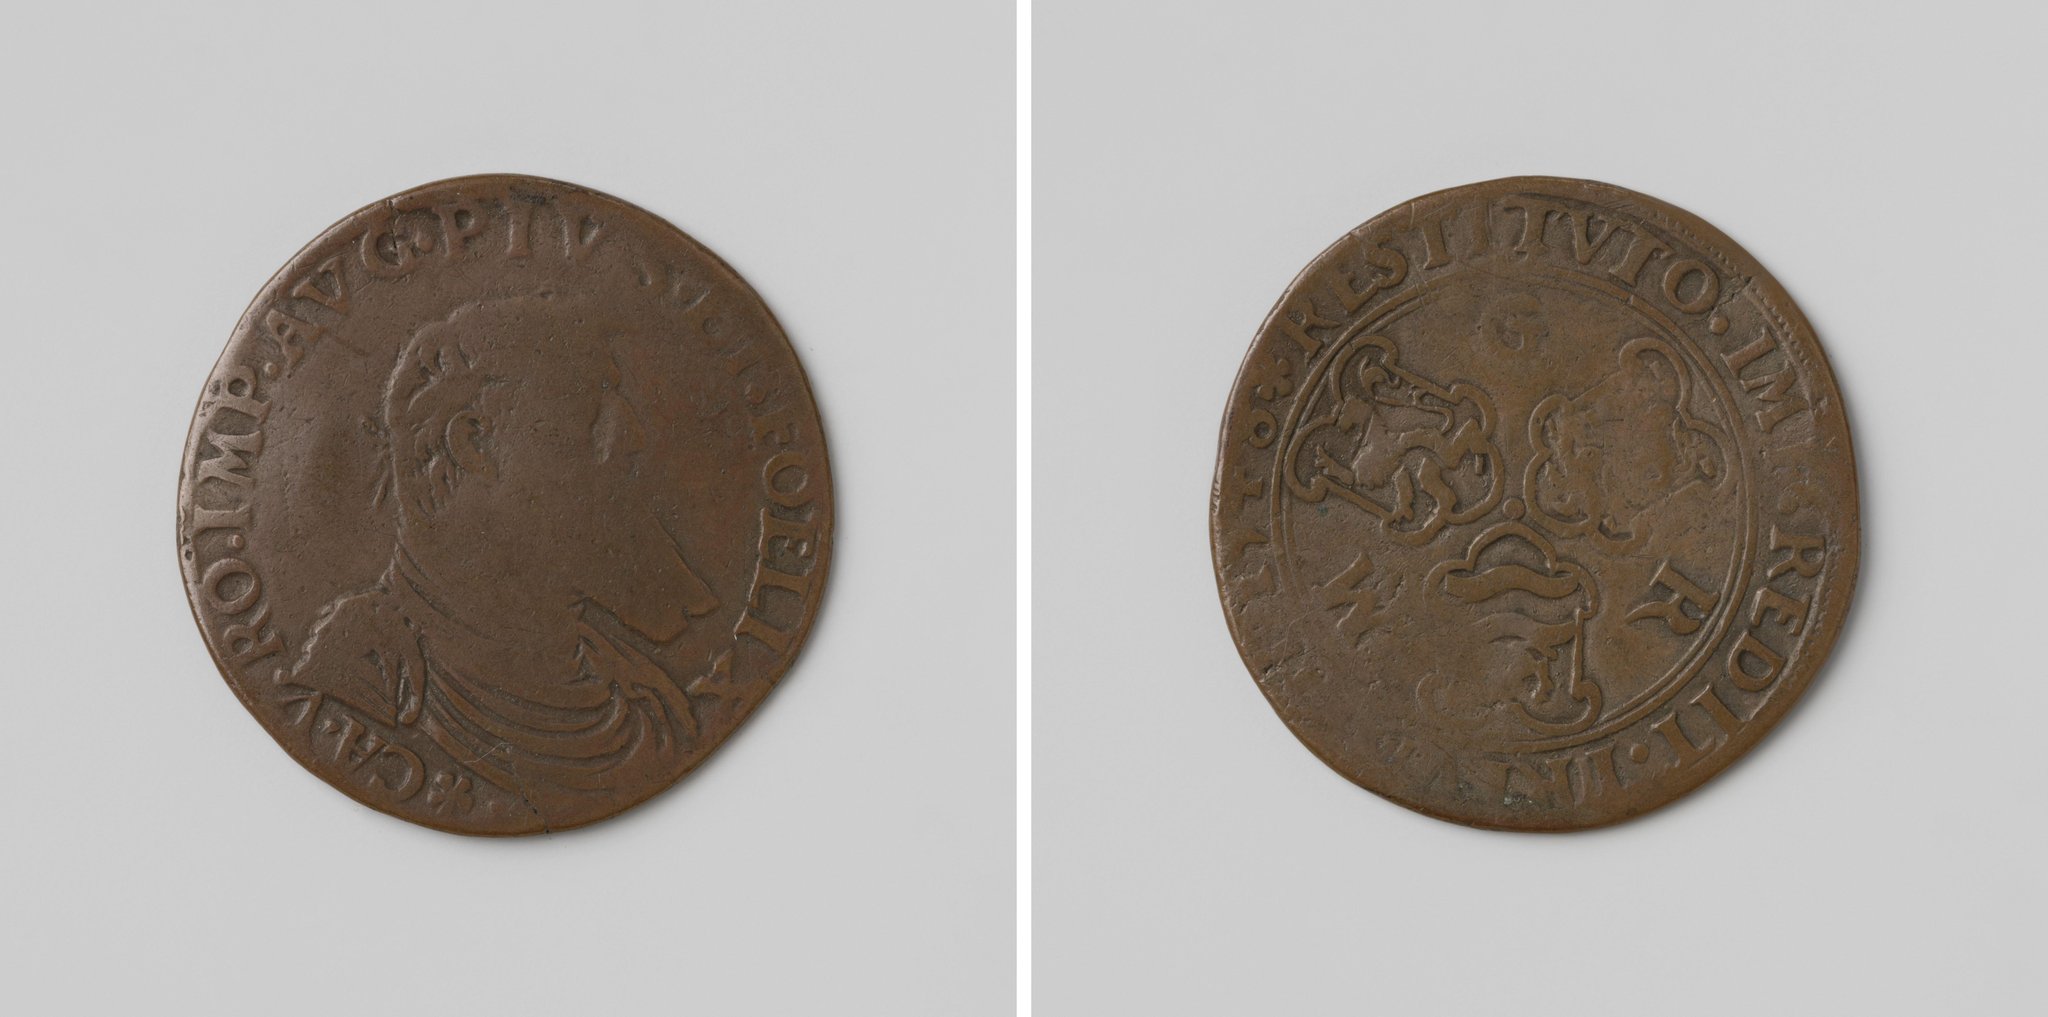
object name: jeton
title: Herstel van de vrede in Duitsland op het Interim van Augsburg, rekenpenning ten behoeve van Mr. Gerrit van Renoy, auditeur van de rekenkamer van Holland te 's-Gravenhage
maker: Anonymous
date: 1548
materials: copper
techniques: striking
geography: netherlands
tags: charles v (holy roman emperor and king of spain), the hague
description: Koperen penning. Voorzijde: borststuk man met lauwerkrans binnen omschrift. Keerzijde: drie in kring geplaatste wapenschilden; daartussen letters M, G en R binnen omschrift